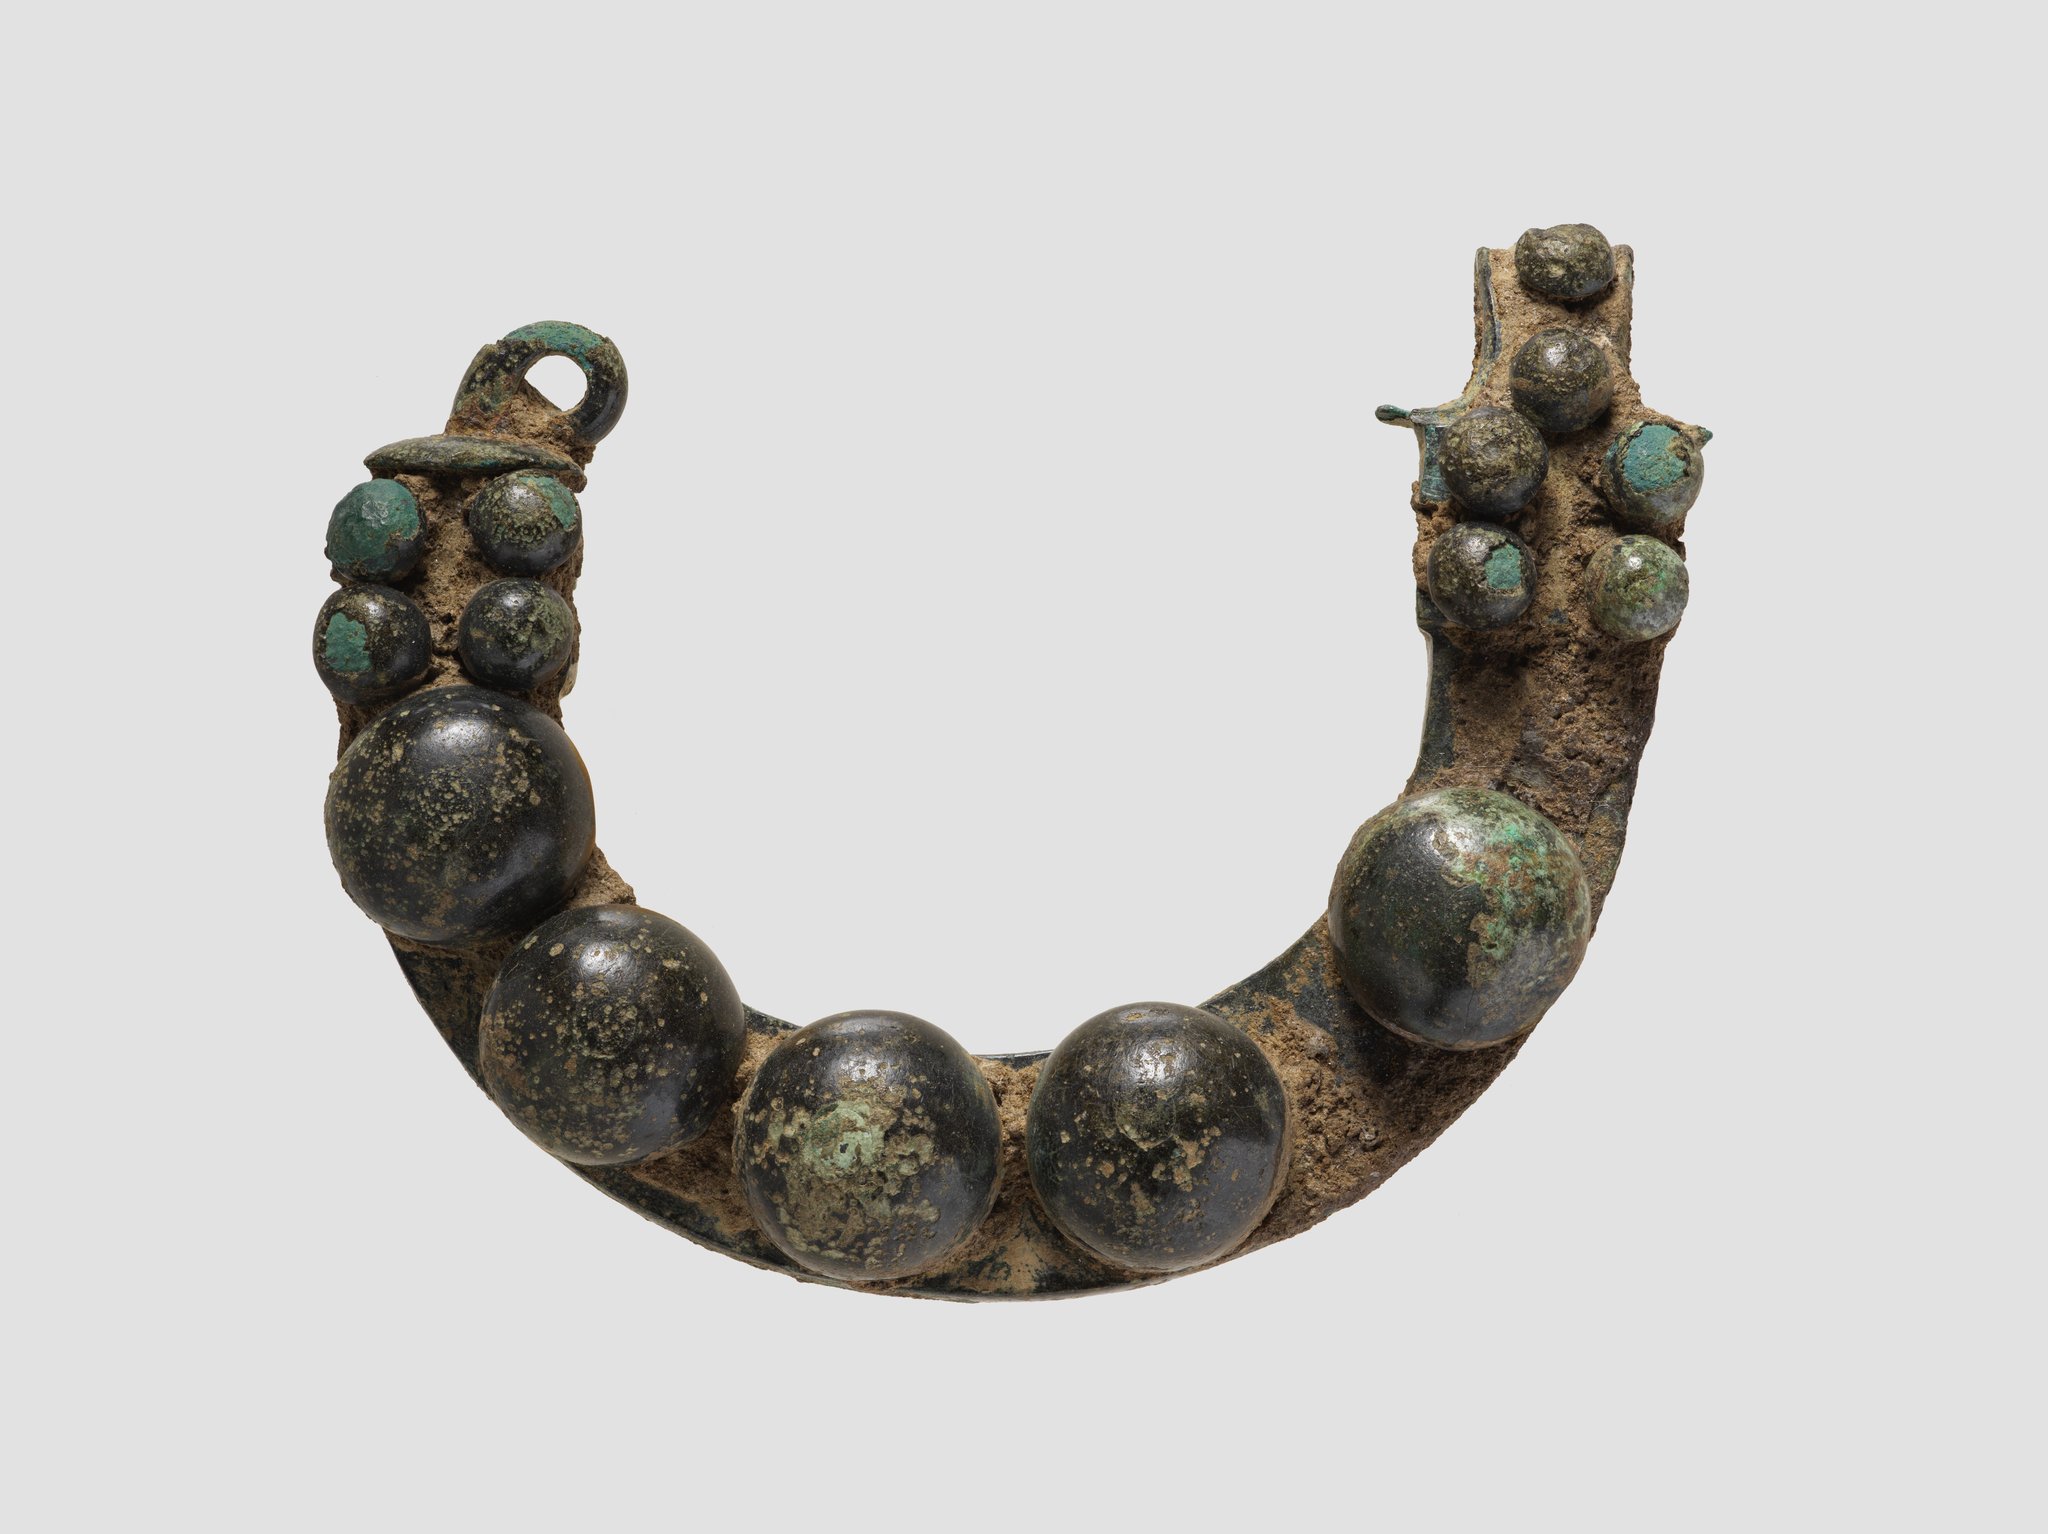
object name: fibula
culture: phrygian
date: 800-601 BCE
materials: bronze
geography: phrygia